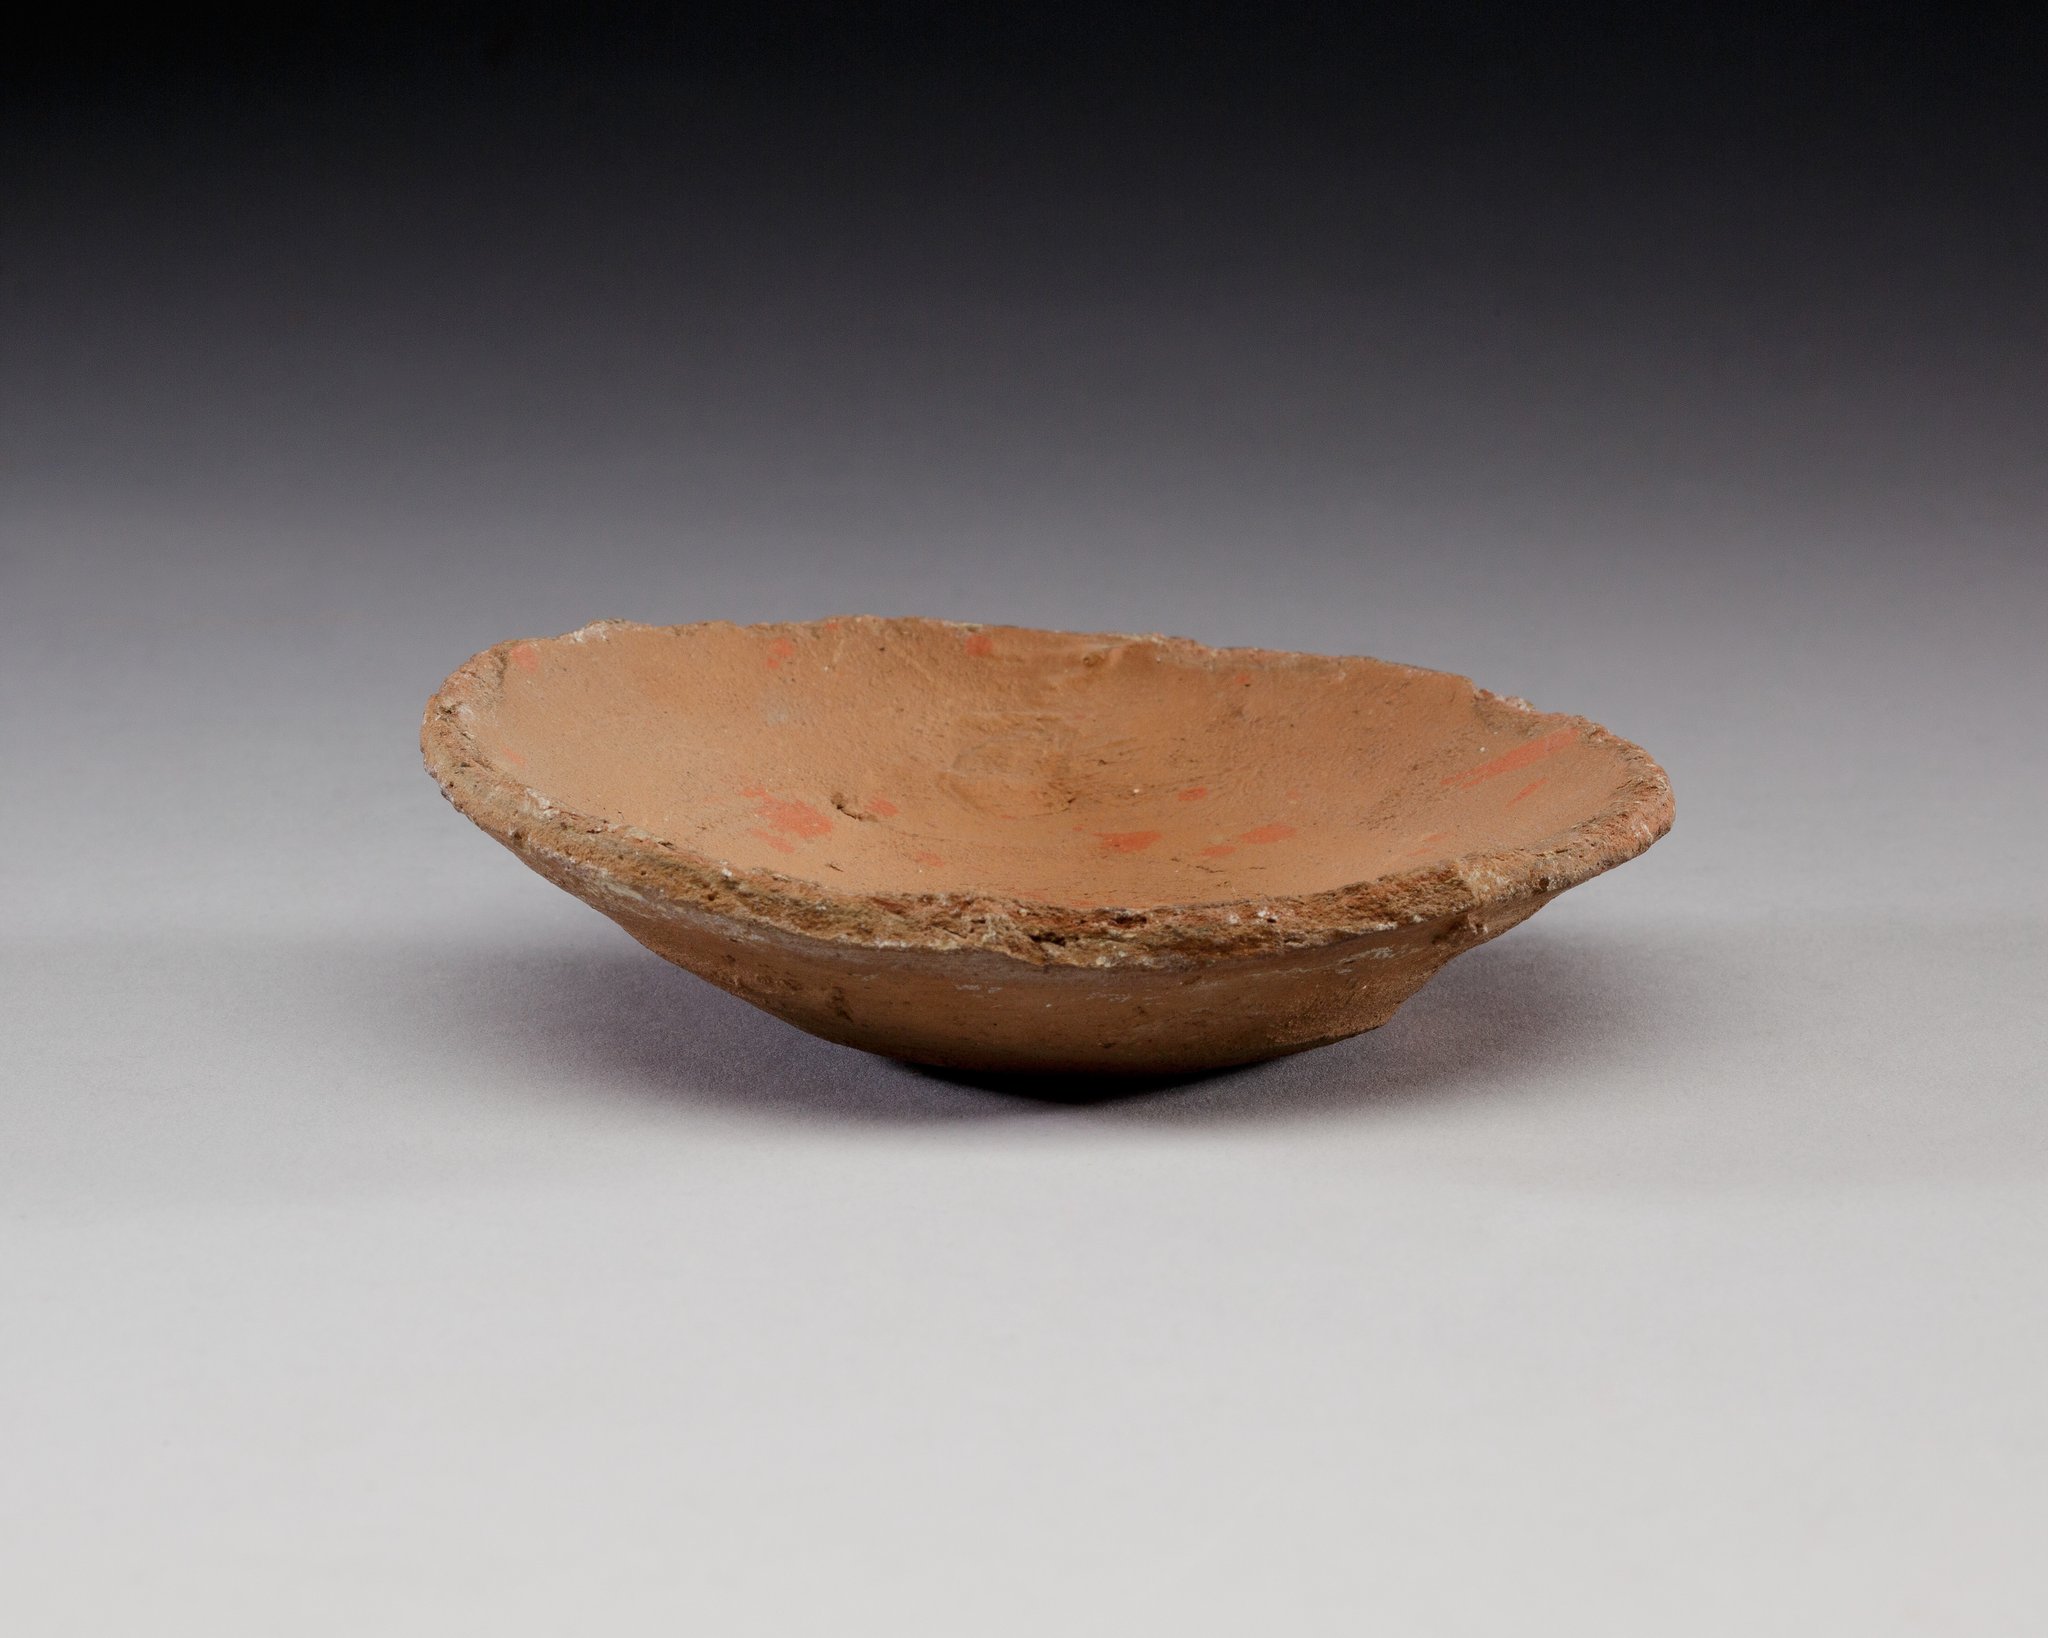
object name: lid, bowl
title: Bowl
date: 1479-1458 BCE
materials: paint, pottery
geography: egypt